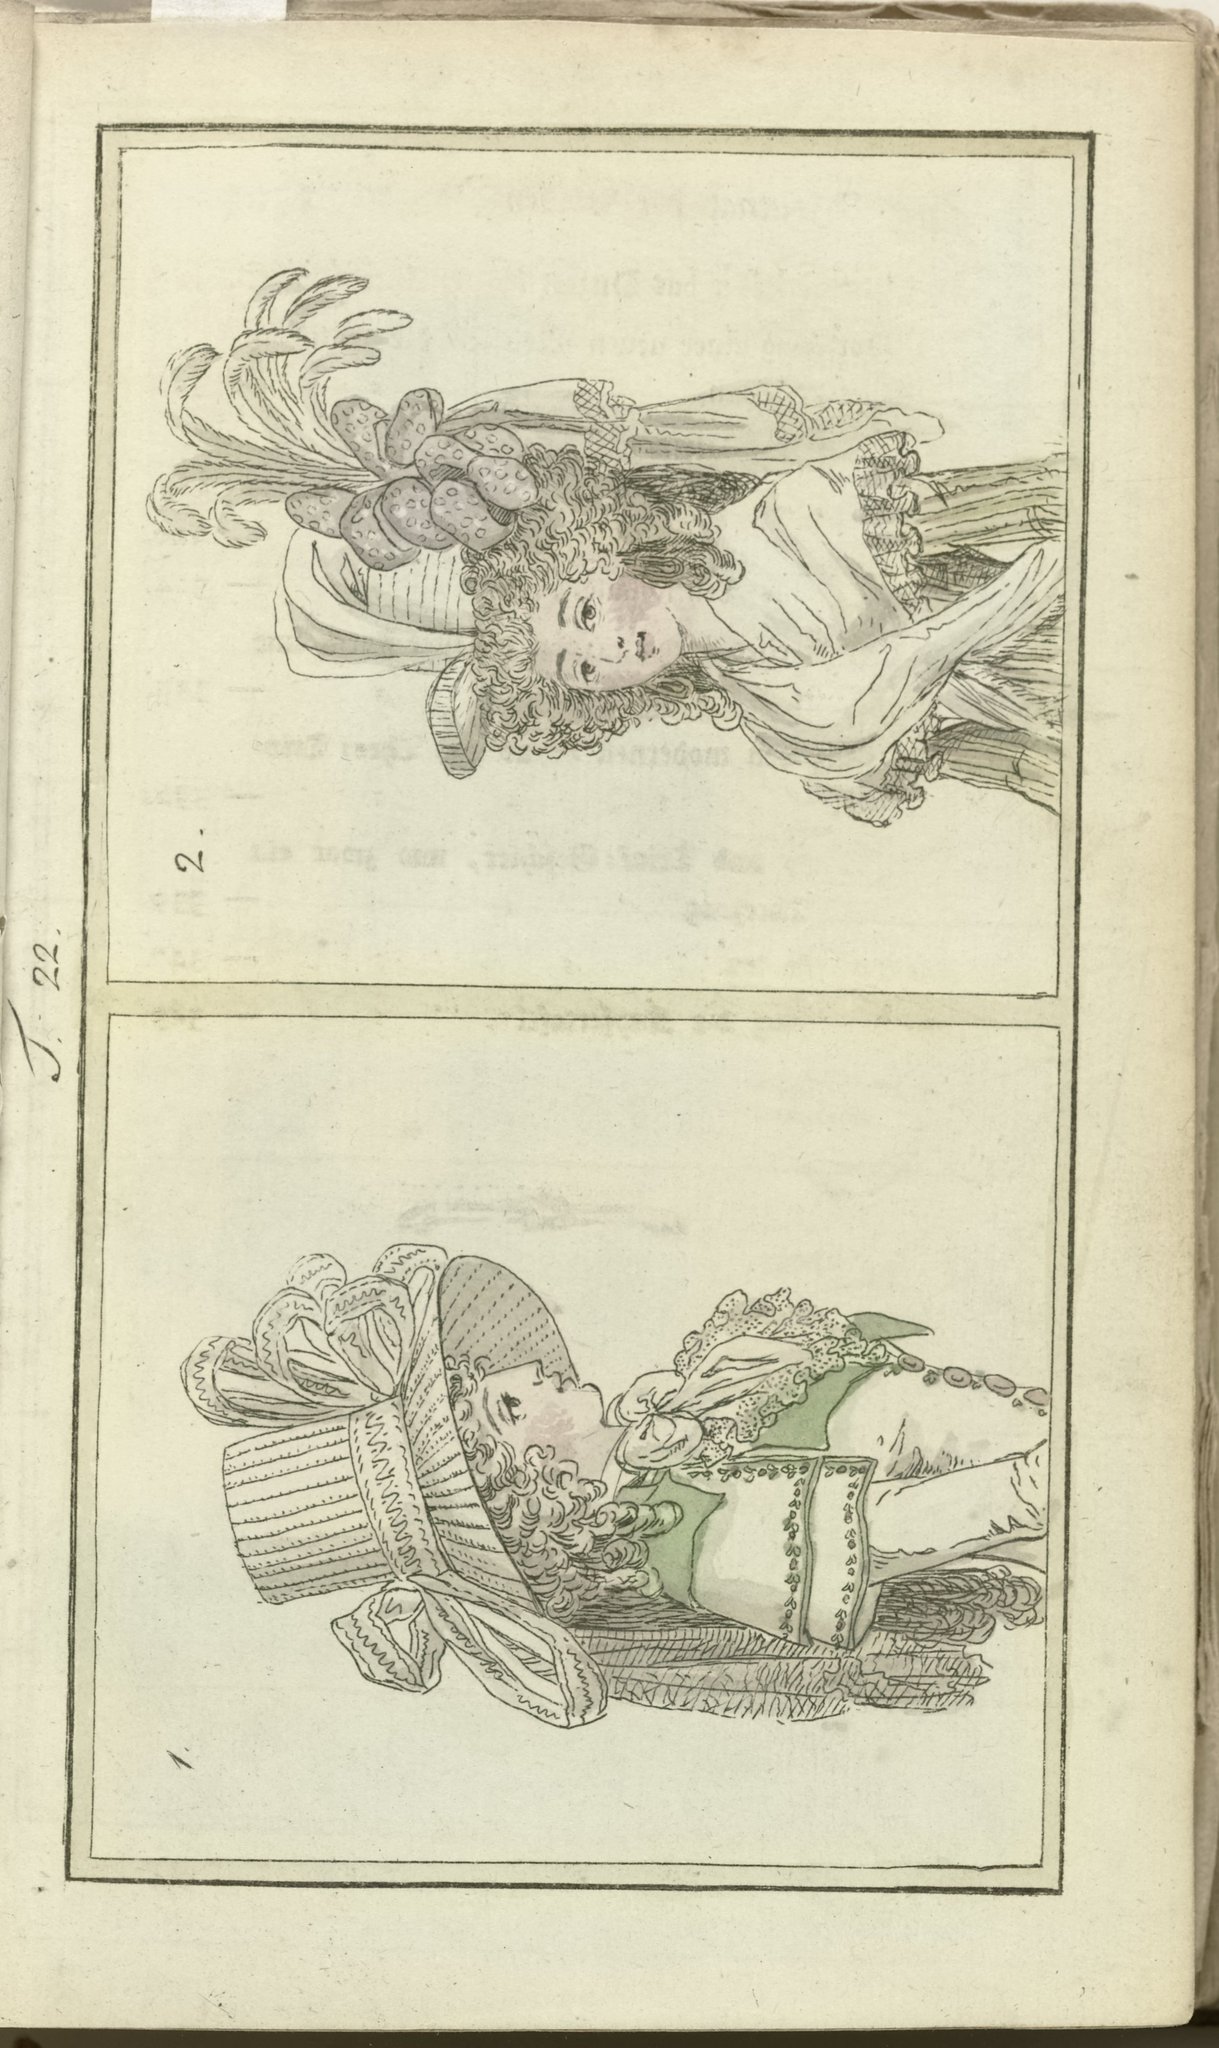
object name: fashion print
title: Journal des Luxus und der Moden 1788, Band III, T.22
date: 1788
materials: paper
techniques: etching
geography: weimar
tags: fashion plates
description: Prent uit het modetijdschrift Journal des Luxus und der Moden, uitgegeven door Friedrich Justin Bertuch en Georg Melchior Kraus, Weimar, 1786-1826.